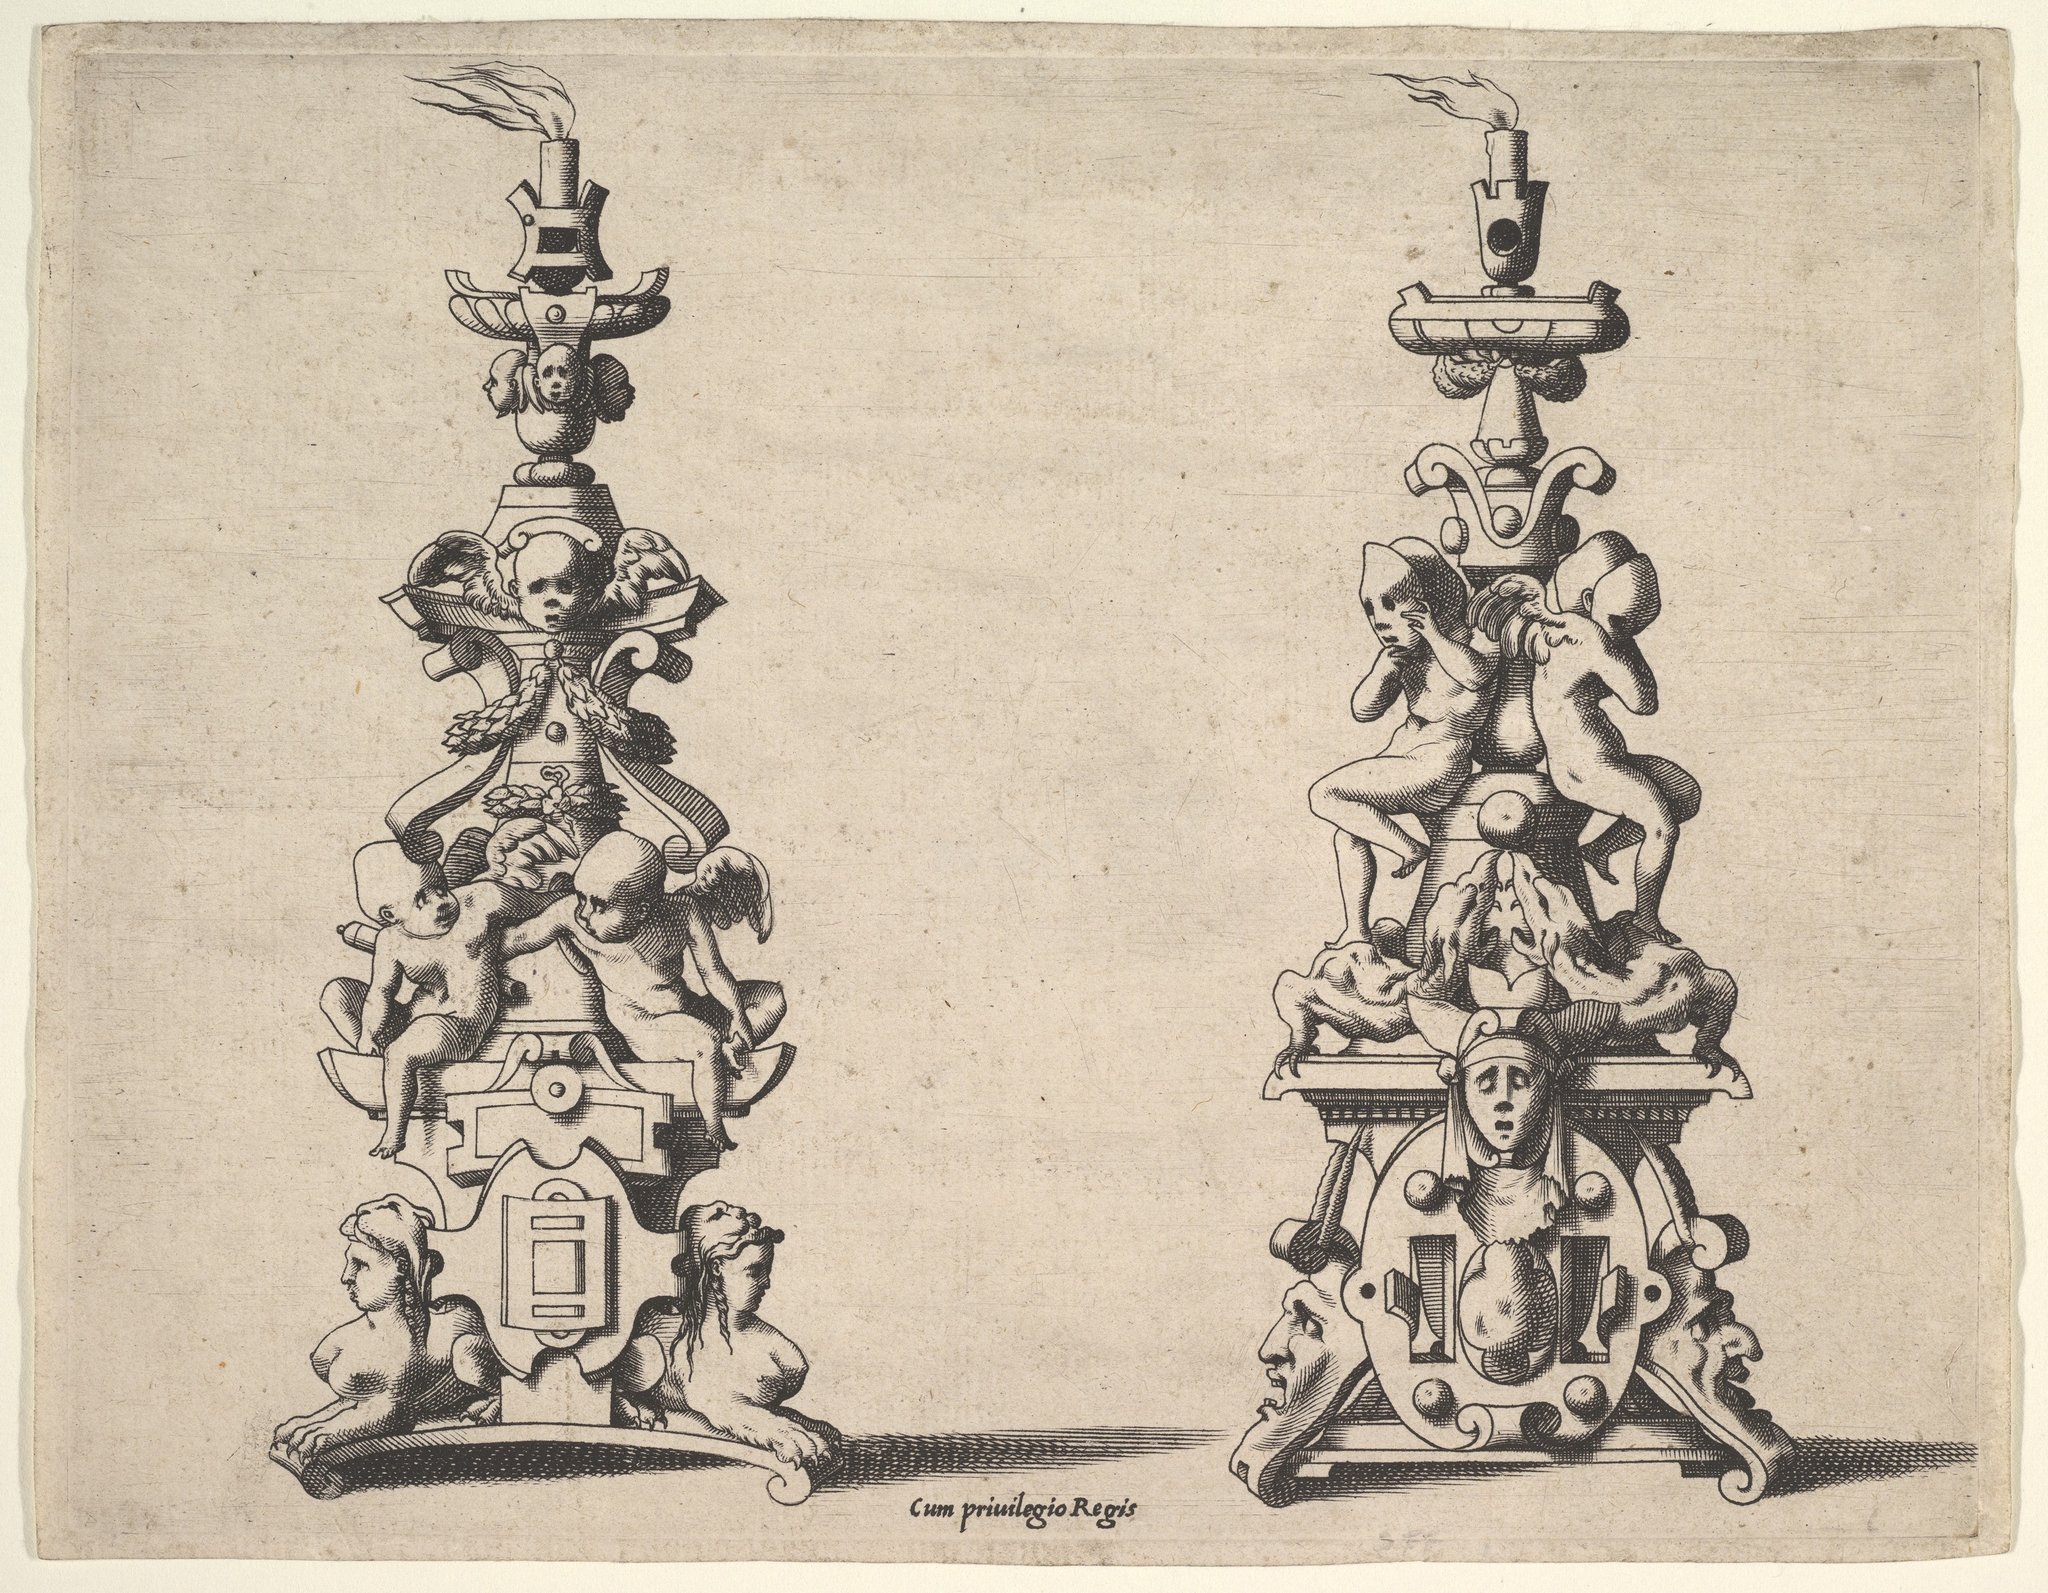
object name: print ornament architecture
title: Two candlestick designs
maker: rené boyvin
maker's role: artist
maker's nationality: french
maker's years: 1525-1598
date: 1550-1560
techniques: engraving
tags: sphinx,candlesticks